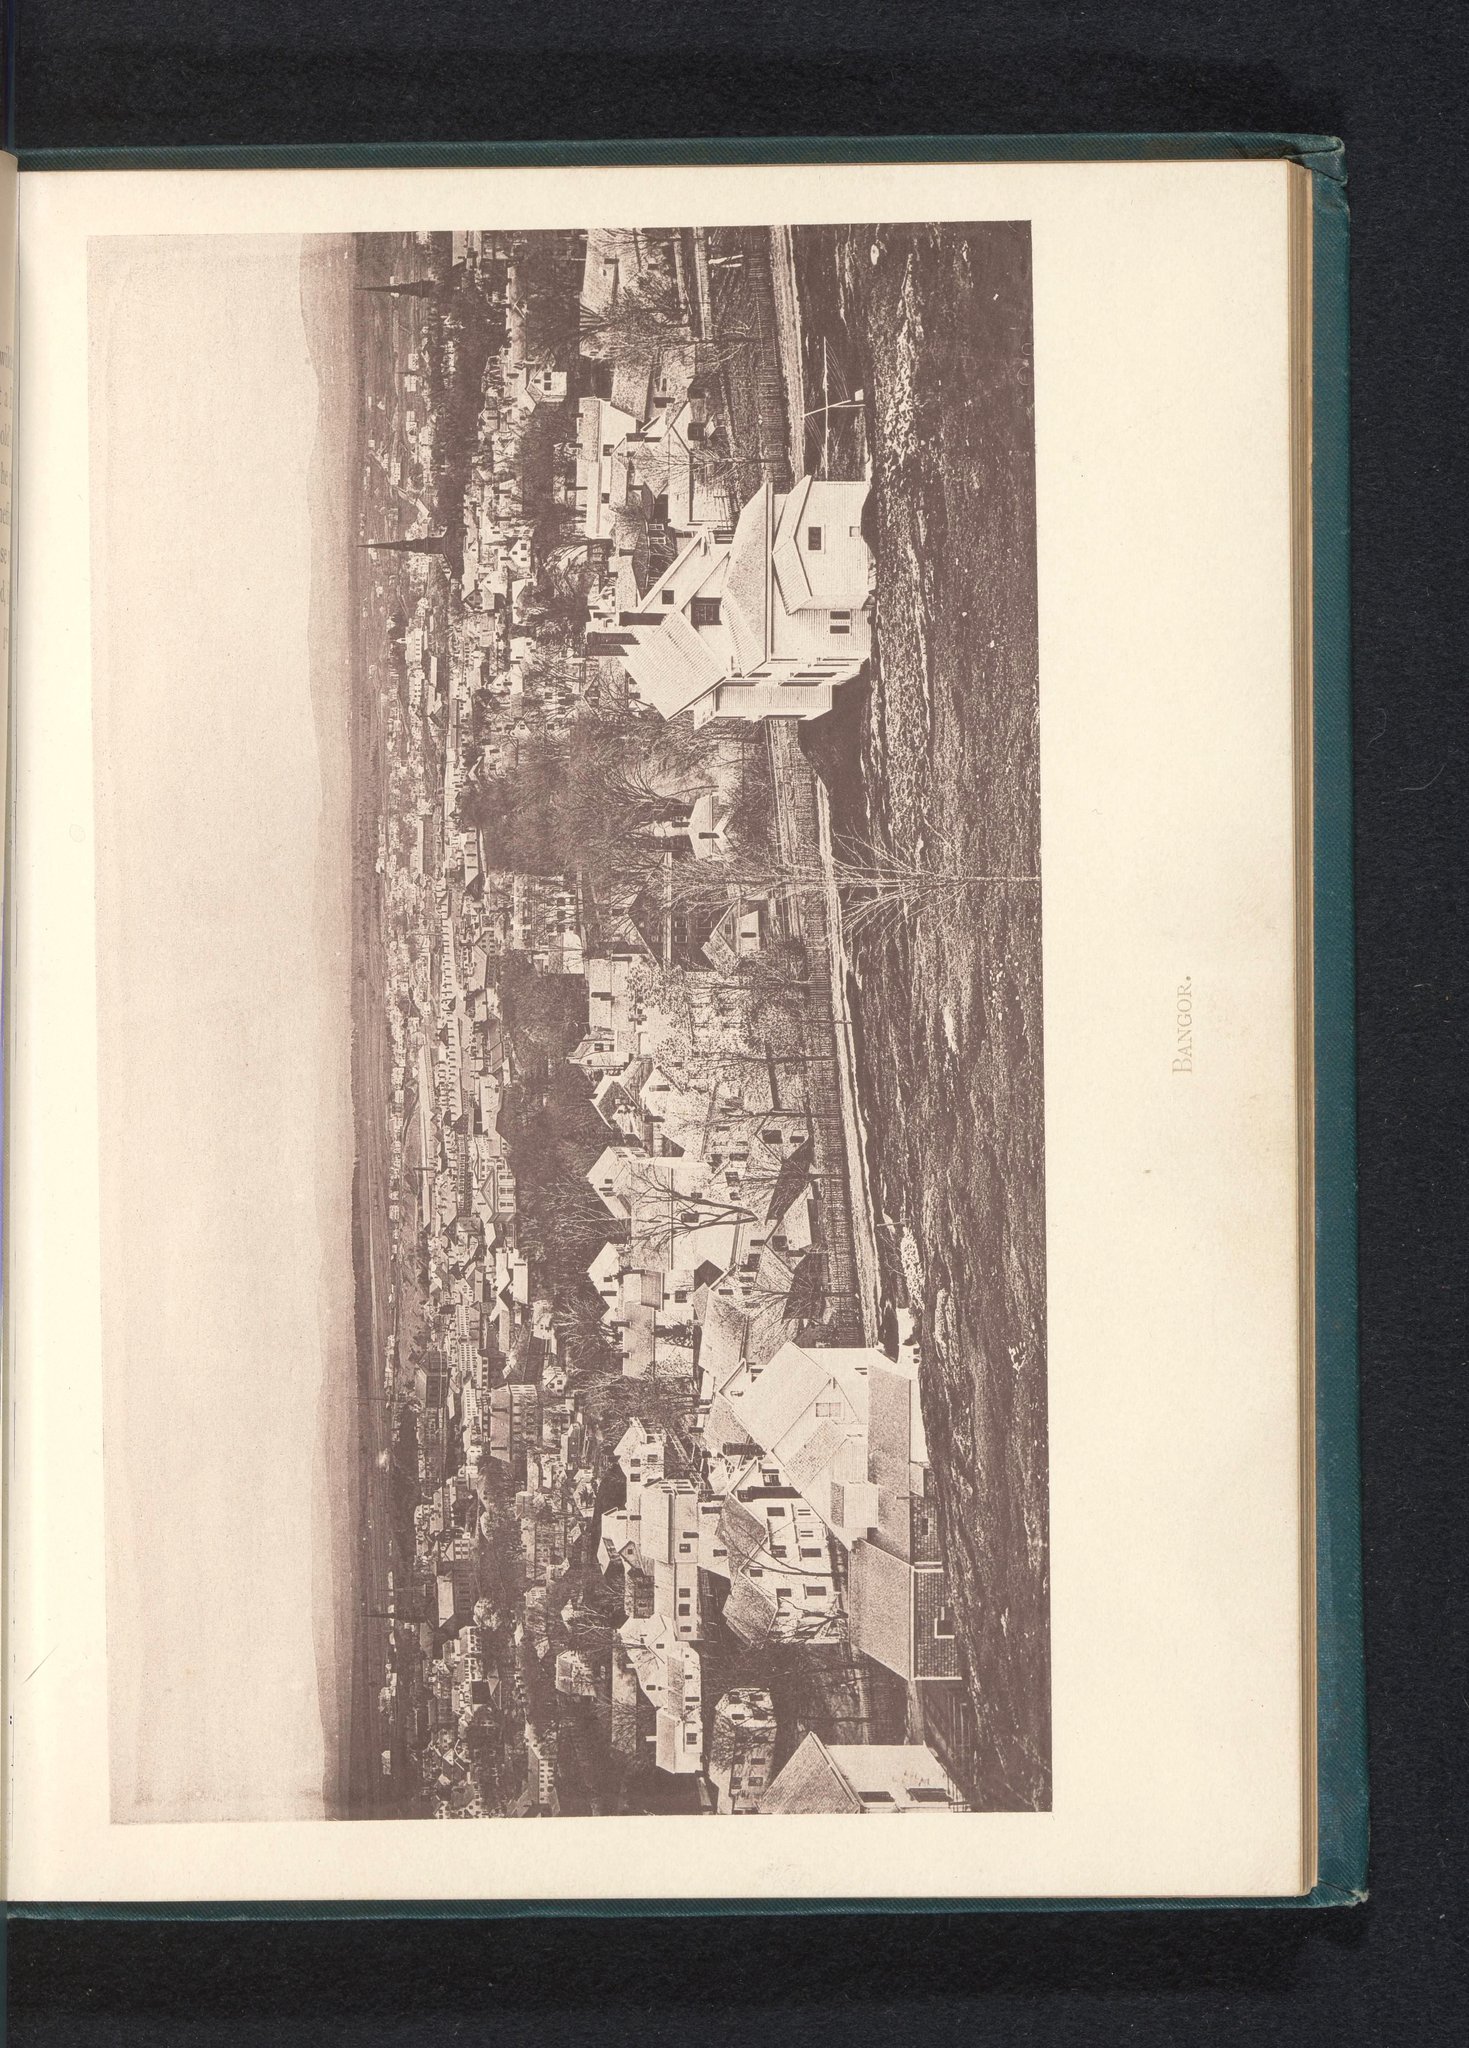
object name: page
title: Bangor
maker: Anonymous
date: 1875-1880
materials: paper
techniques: photograph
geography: bangor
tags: city-view, and landscape with man-made constructions